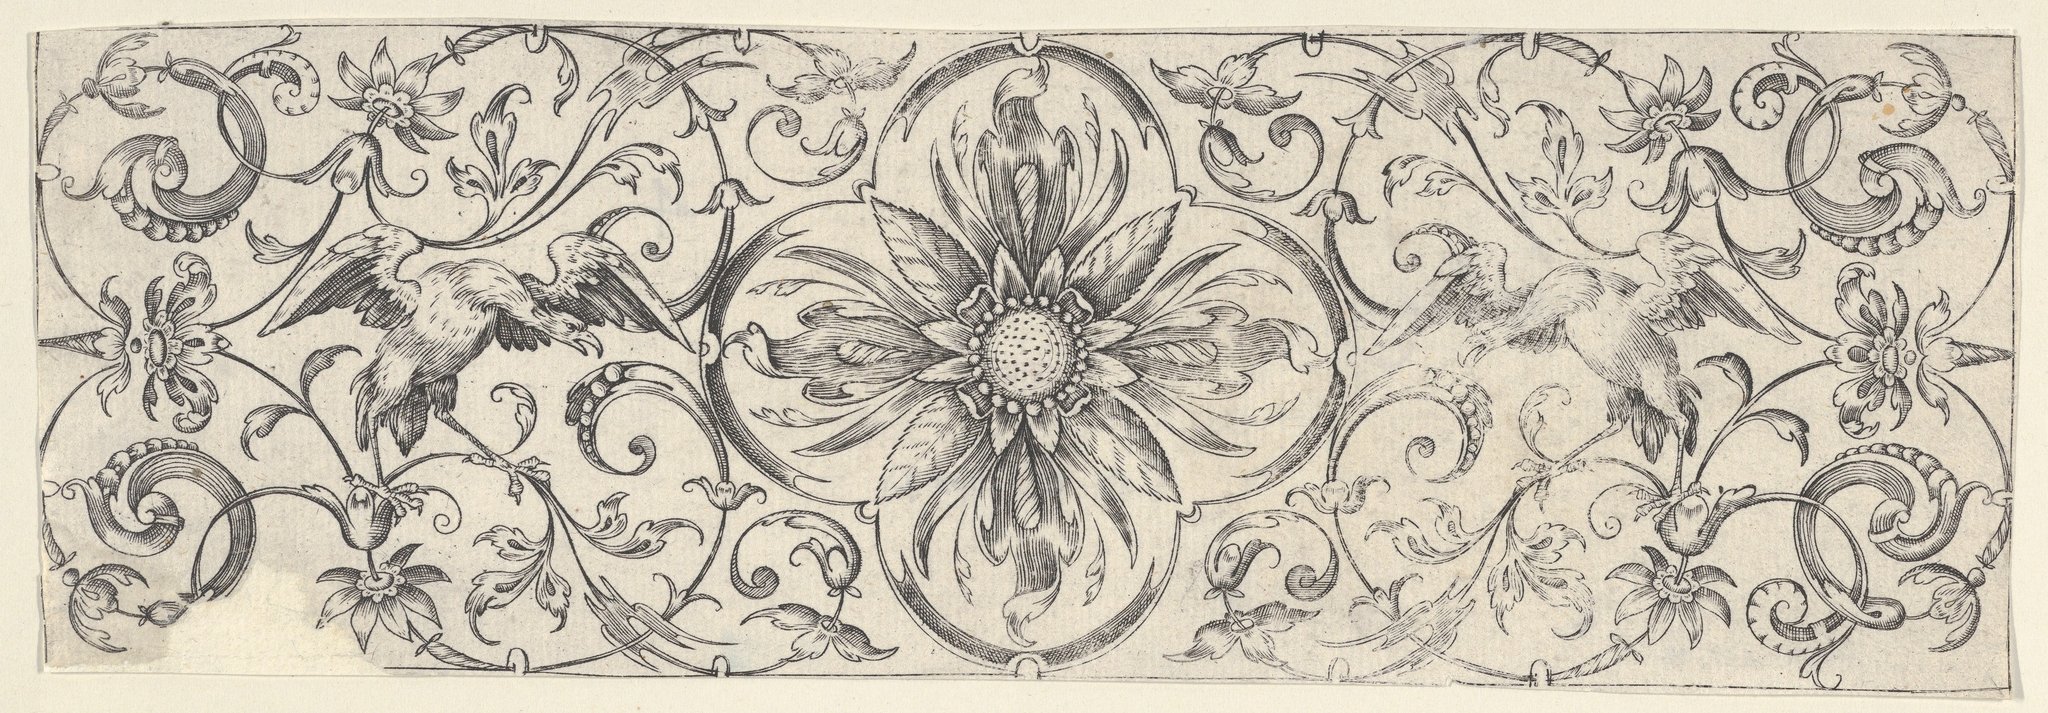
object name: ornament architecture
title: Plate 6, from "Friezes with Birds, Flowers and Meandering Wreaths and Scrolls"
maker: theodor bang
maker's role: artist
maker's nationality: german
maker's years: 1606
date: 1600-1617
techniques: etching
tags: birds,flowers